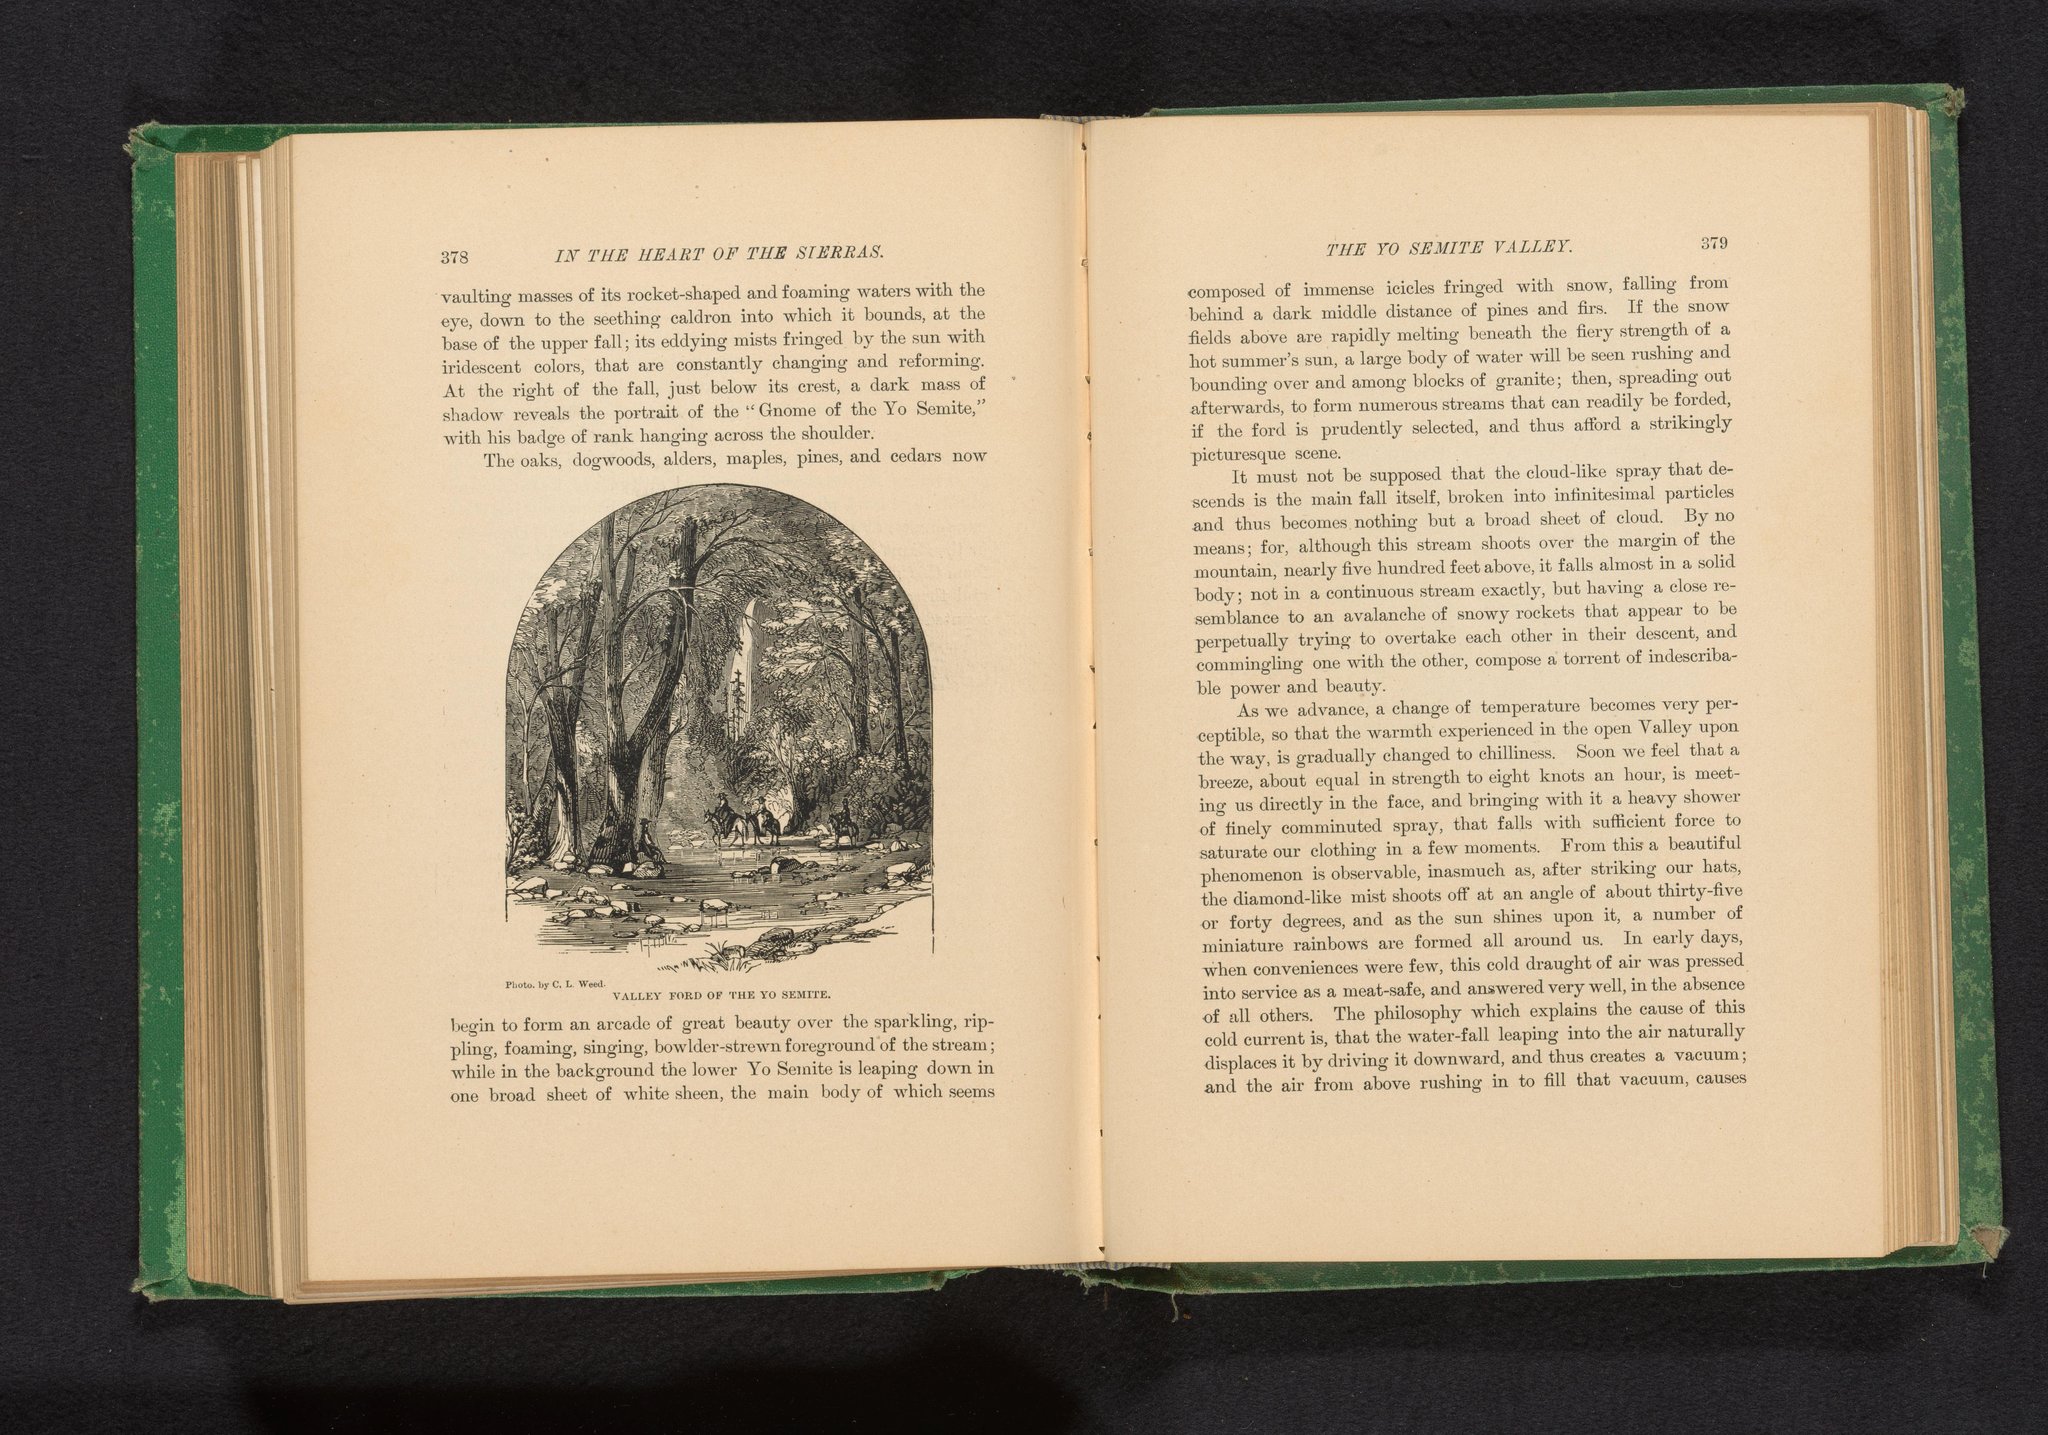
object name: photomechanical print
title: Twee mannen te paard in een bos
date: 1881-1886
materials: paper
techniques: printing block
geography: yosemite valley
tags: adult woman, forest, wood, horse